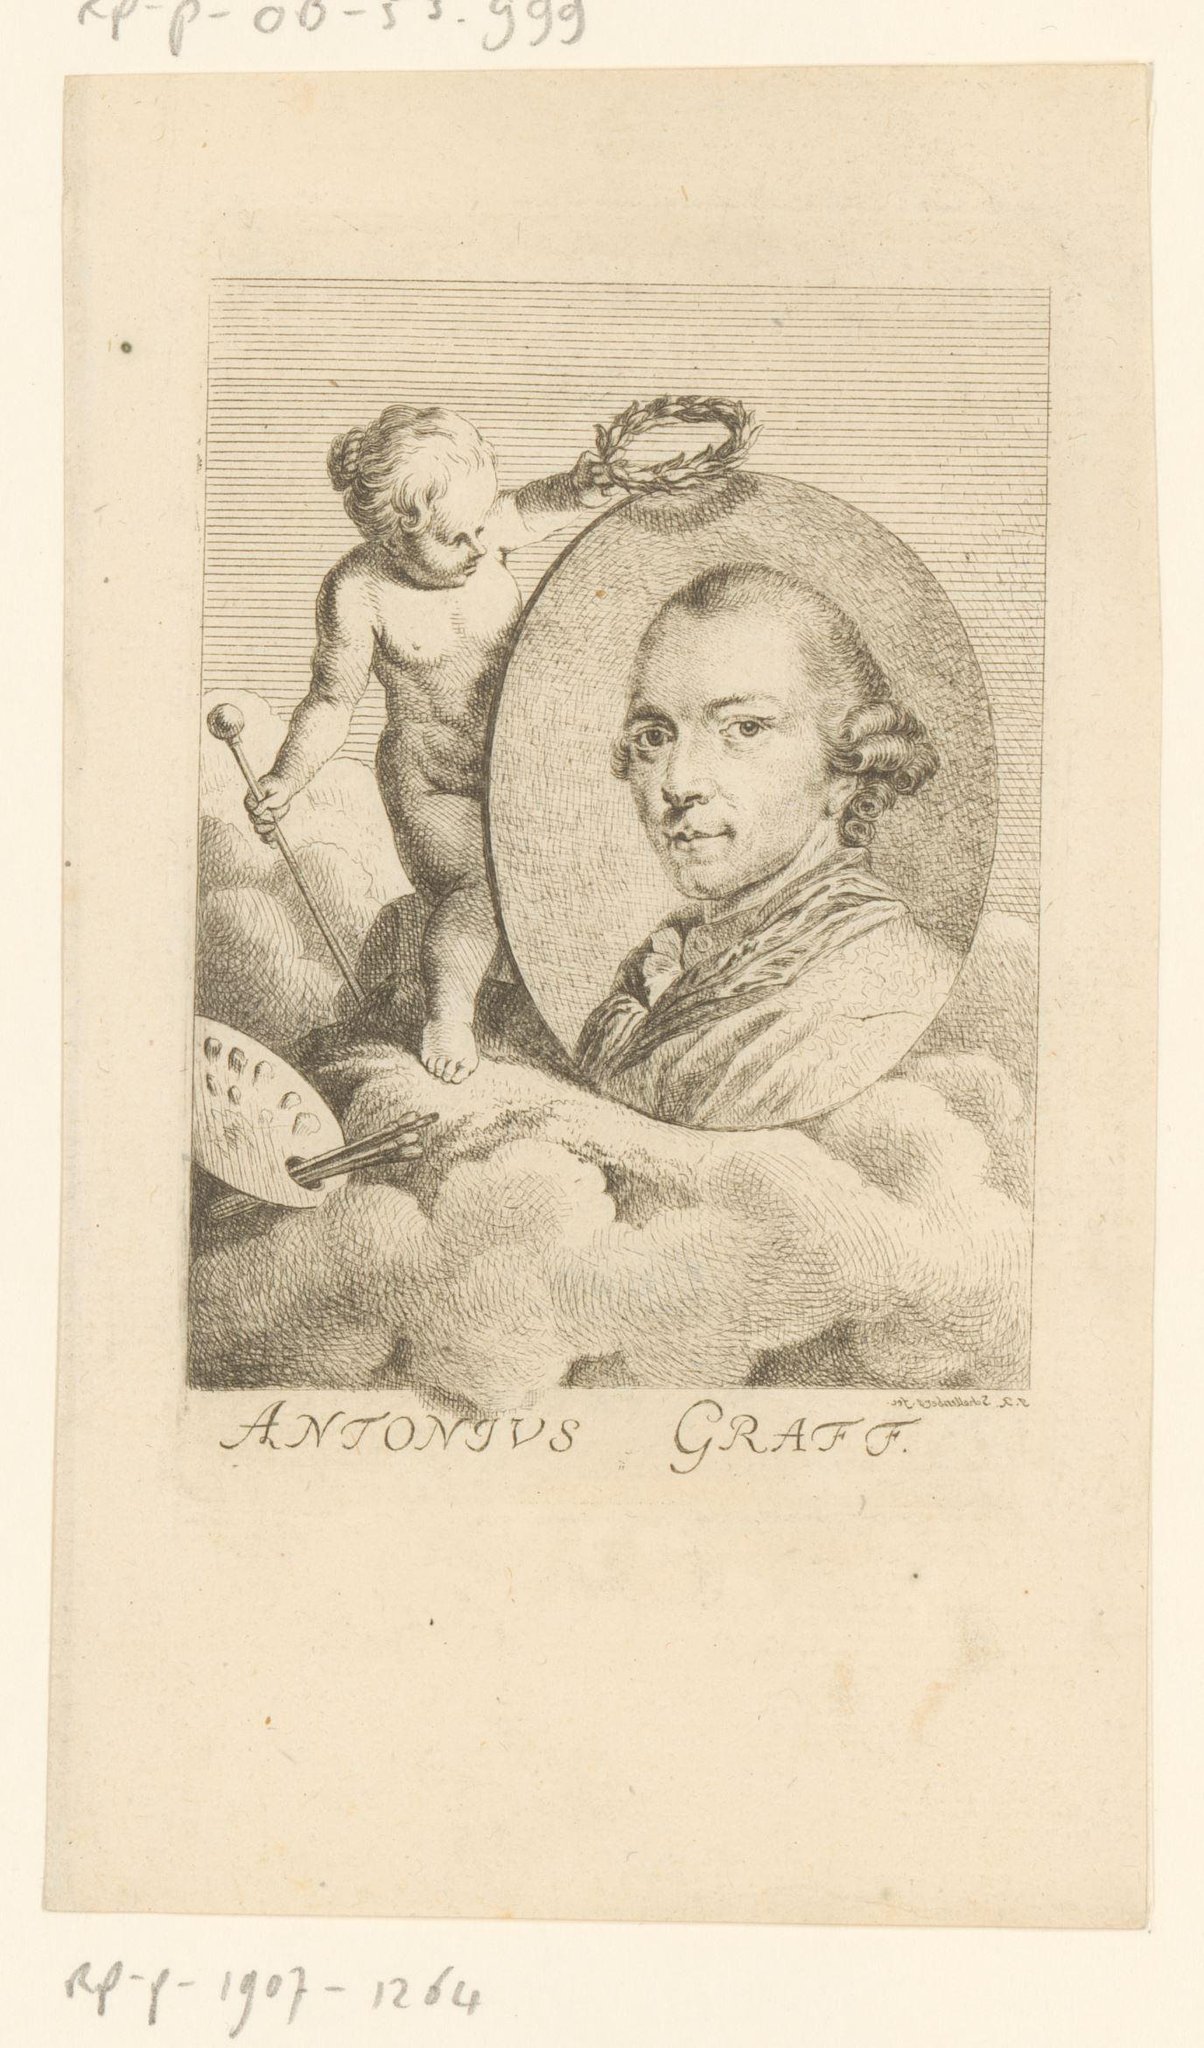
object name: print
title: Portret van Anton Graff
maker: johann rudolph schellenberg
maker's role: print maker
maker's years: 1740-1806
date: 1750-1806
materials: paper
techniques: etching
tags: painter, print maker, anton graff, clouds, portrait, self-portrait of painter, tools, implements of painter, crowning with laurel, cupids: 'amores', 'amoretti', 'putti'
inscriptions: collector's mark: Lugt 2228